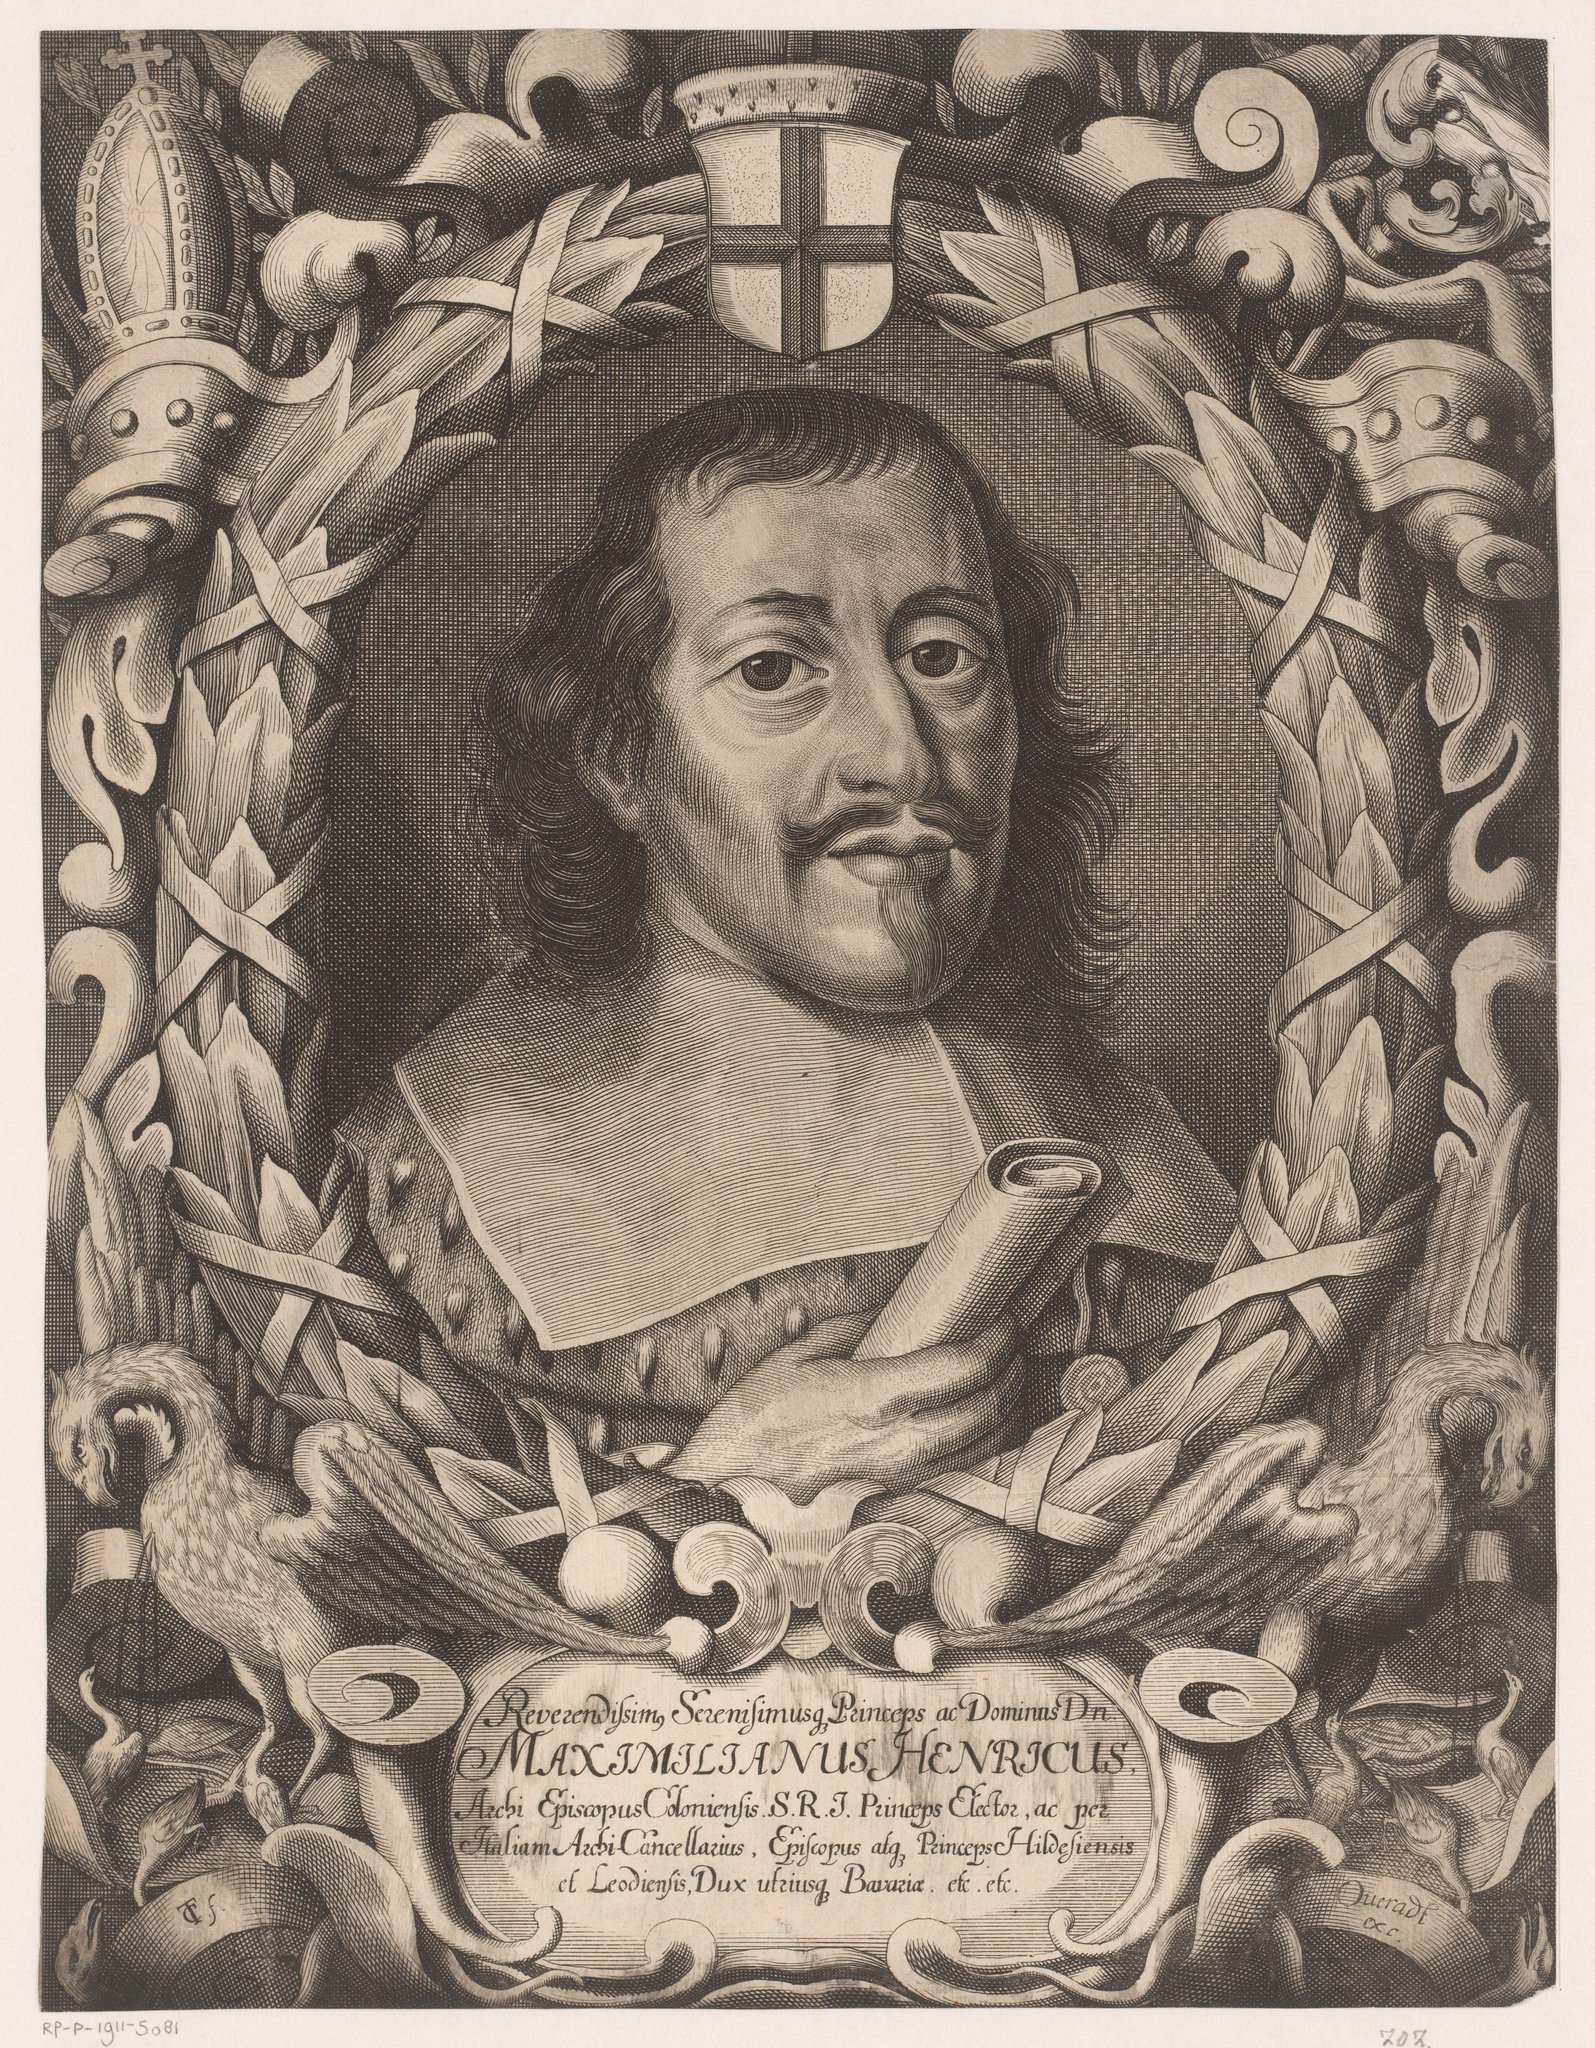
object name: print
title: Portret van Maximiliaan Hendrik van Beieren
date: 1650-1699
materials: paper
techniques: engraving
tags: maximiliaan hendrik van beieren, historical persons, symbols of christ ~ animals, water-birds: pelican